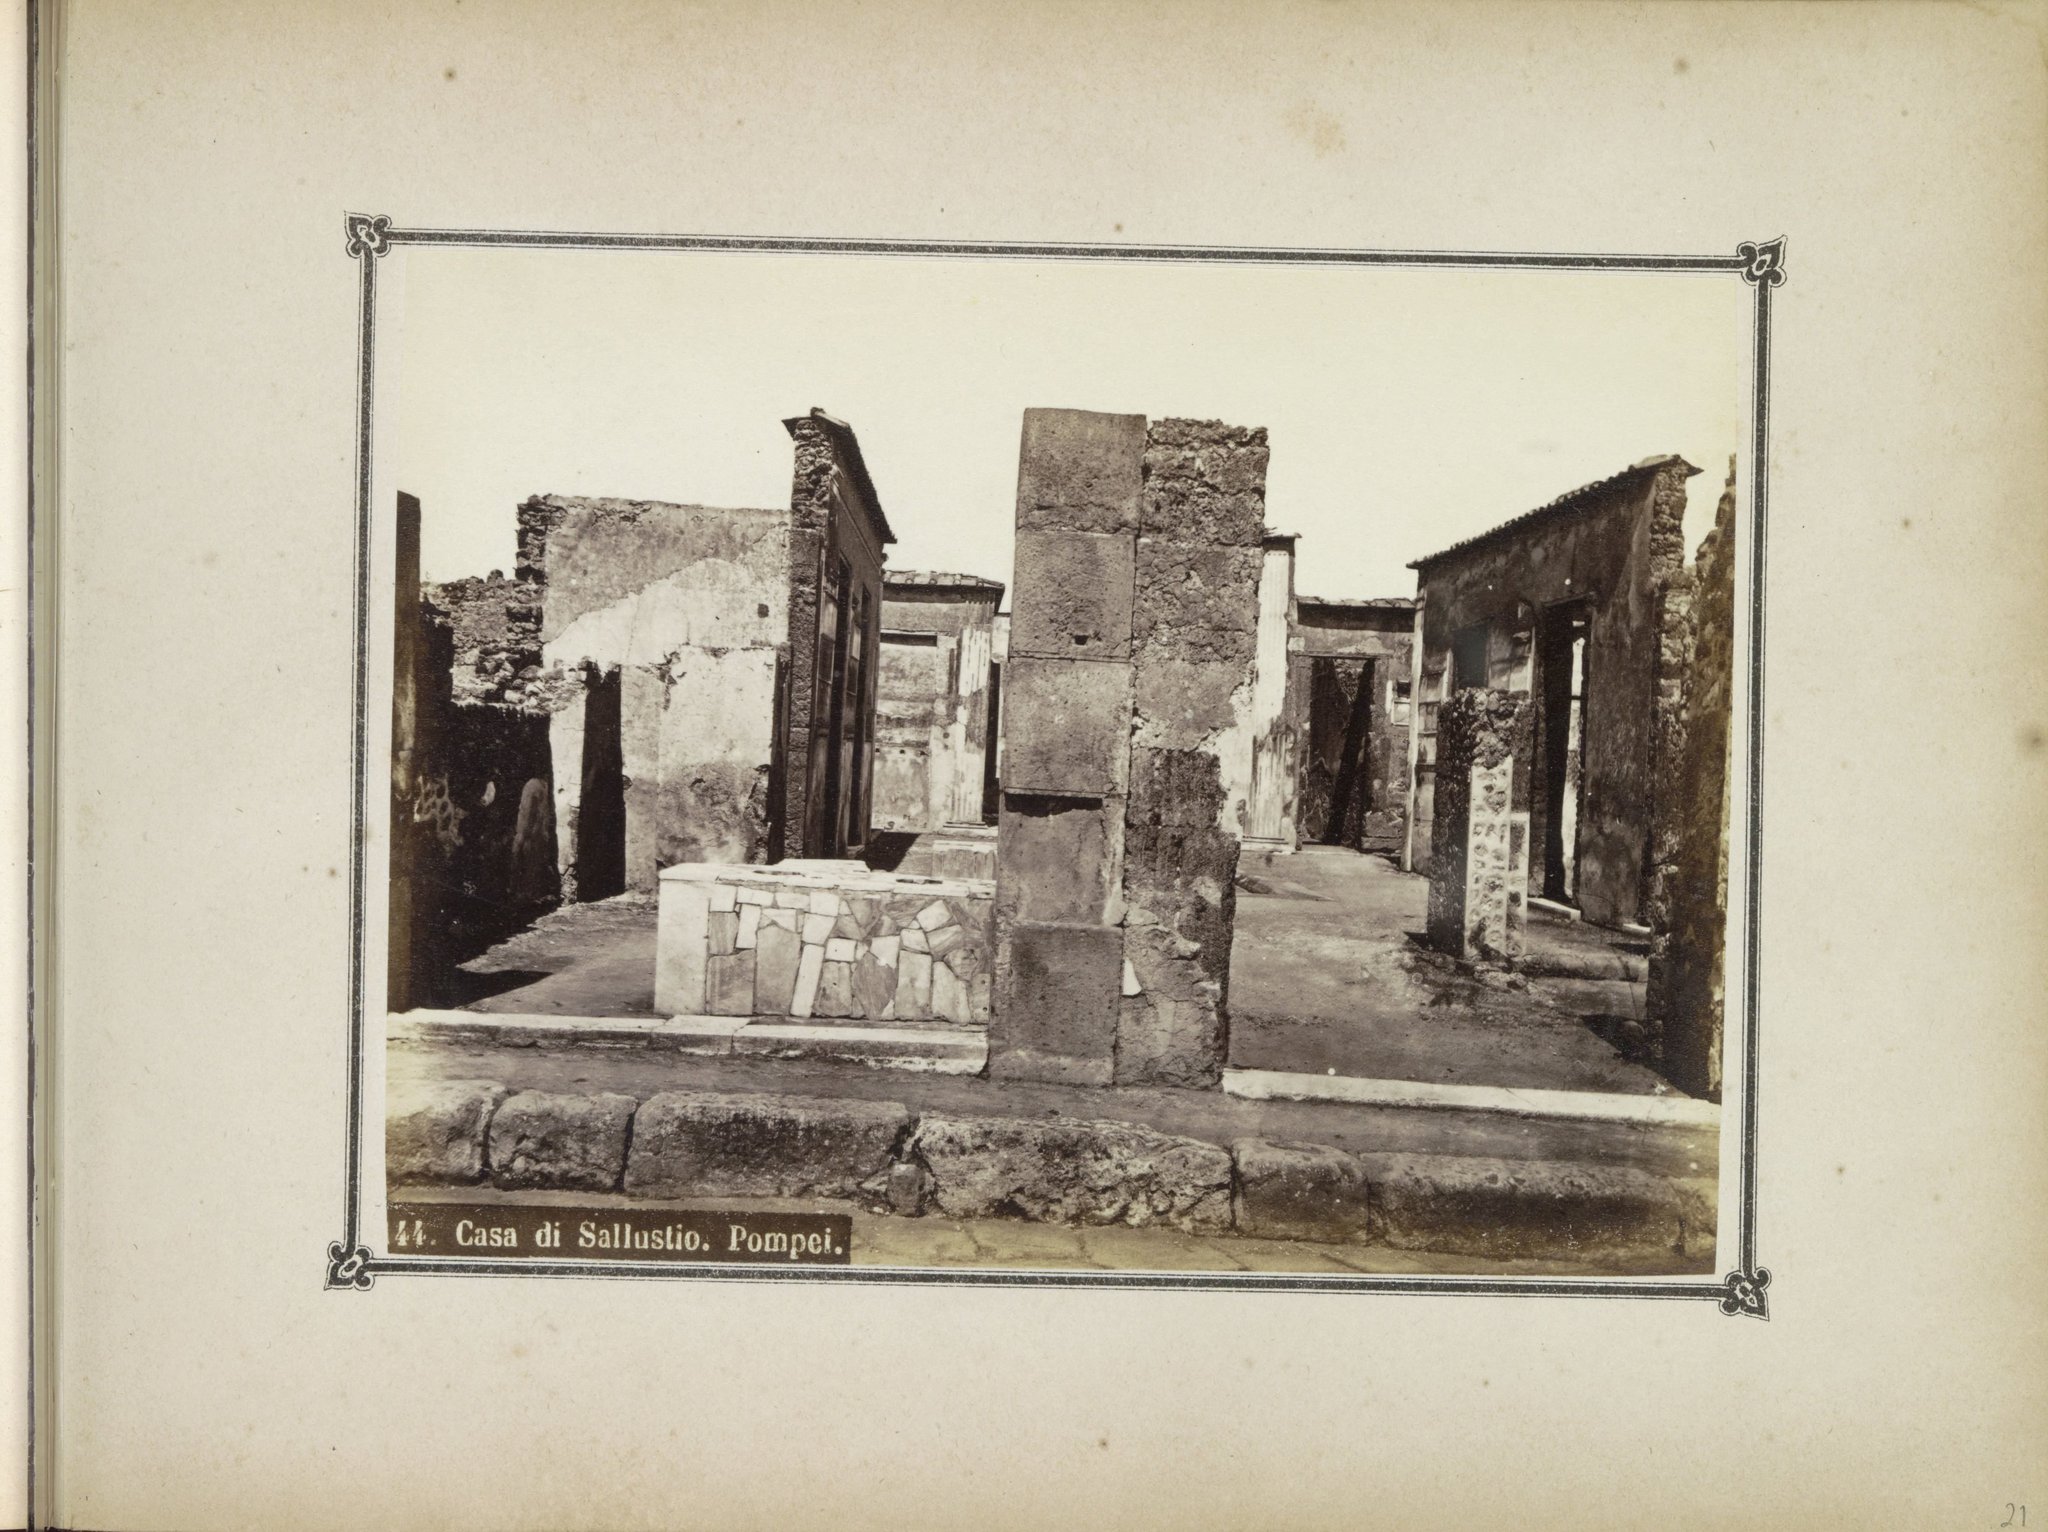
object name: album leaf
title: Restanten van het Huis van Sallustius in Pompeï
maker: roberto rive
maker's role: fotograaf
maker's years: 1825-1868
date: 1860-1900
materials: paper, photographic support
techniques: albumen print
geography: pompeii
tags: villa, excavation ~ archaeology, pompeii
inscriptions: number: ‘44’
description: Onderdeel van Fotoalbum met opnames van opgravingen in Pompeï door Roberto Rive.